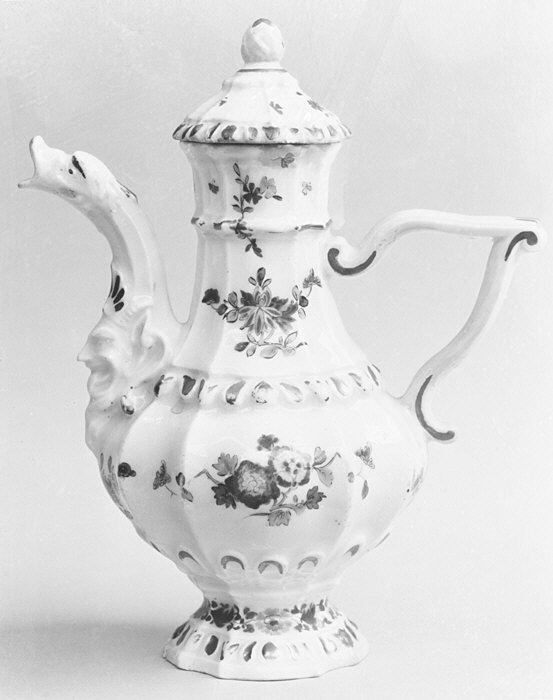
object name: oil pot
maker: meissen manufactory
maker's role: manufactory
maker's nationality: german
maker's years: 1710-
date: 1735-1740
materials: hard paste porcelain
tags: birds,faces,flowers